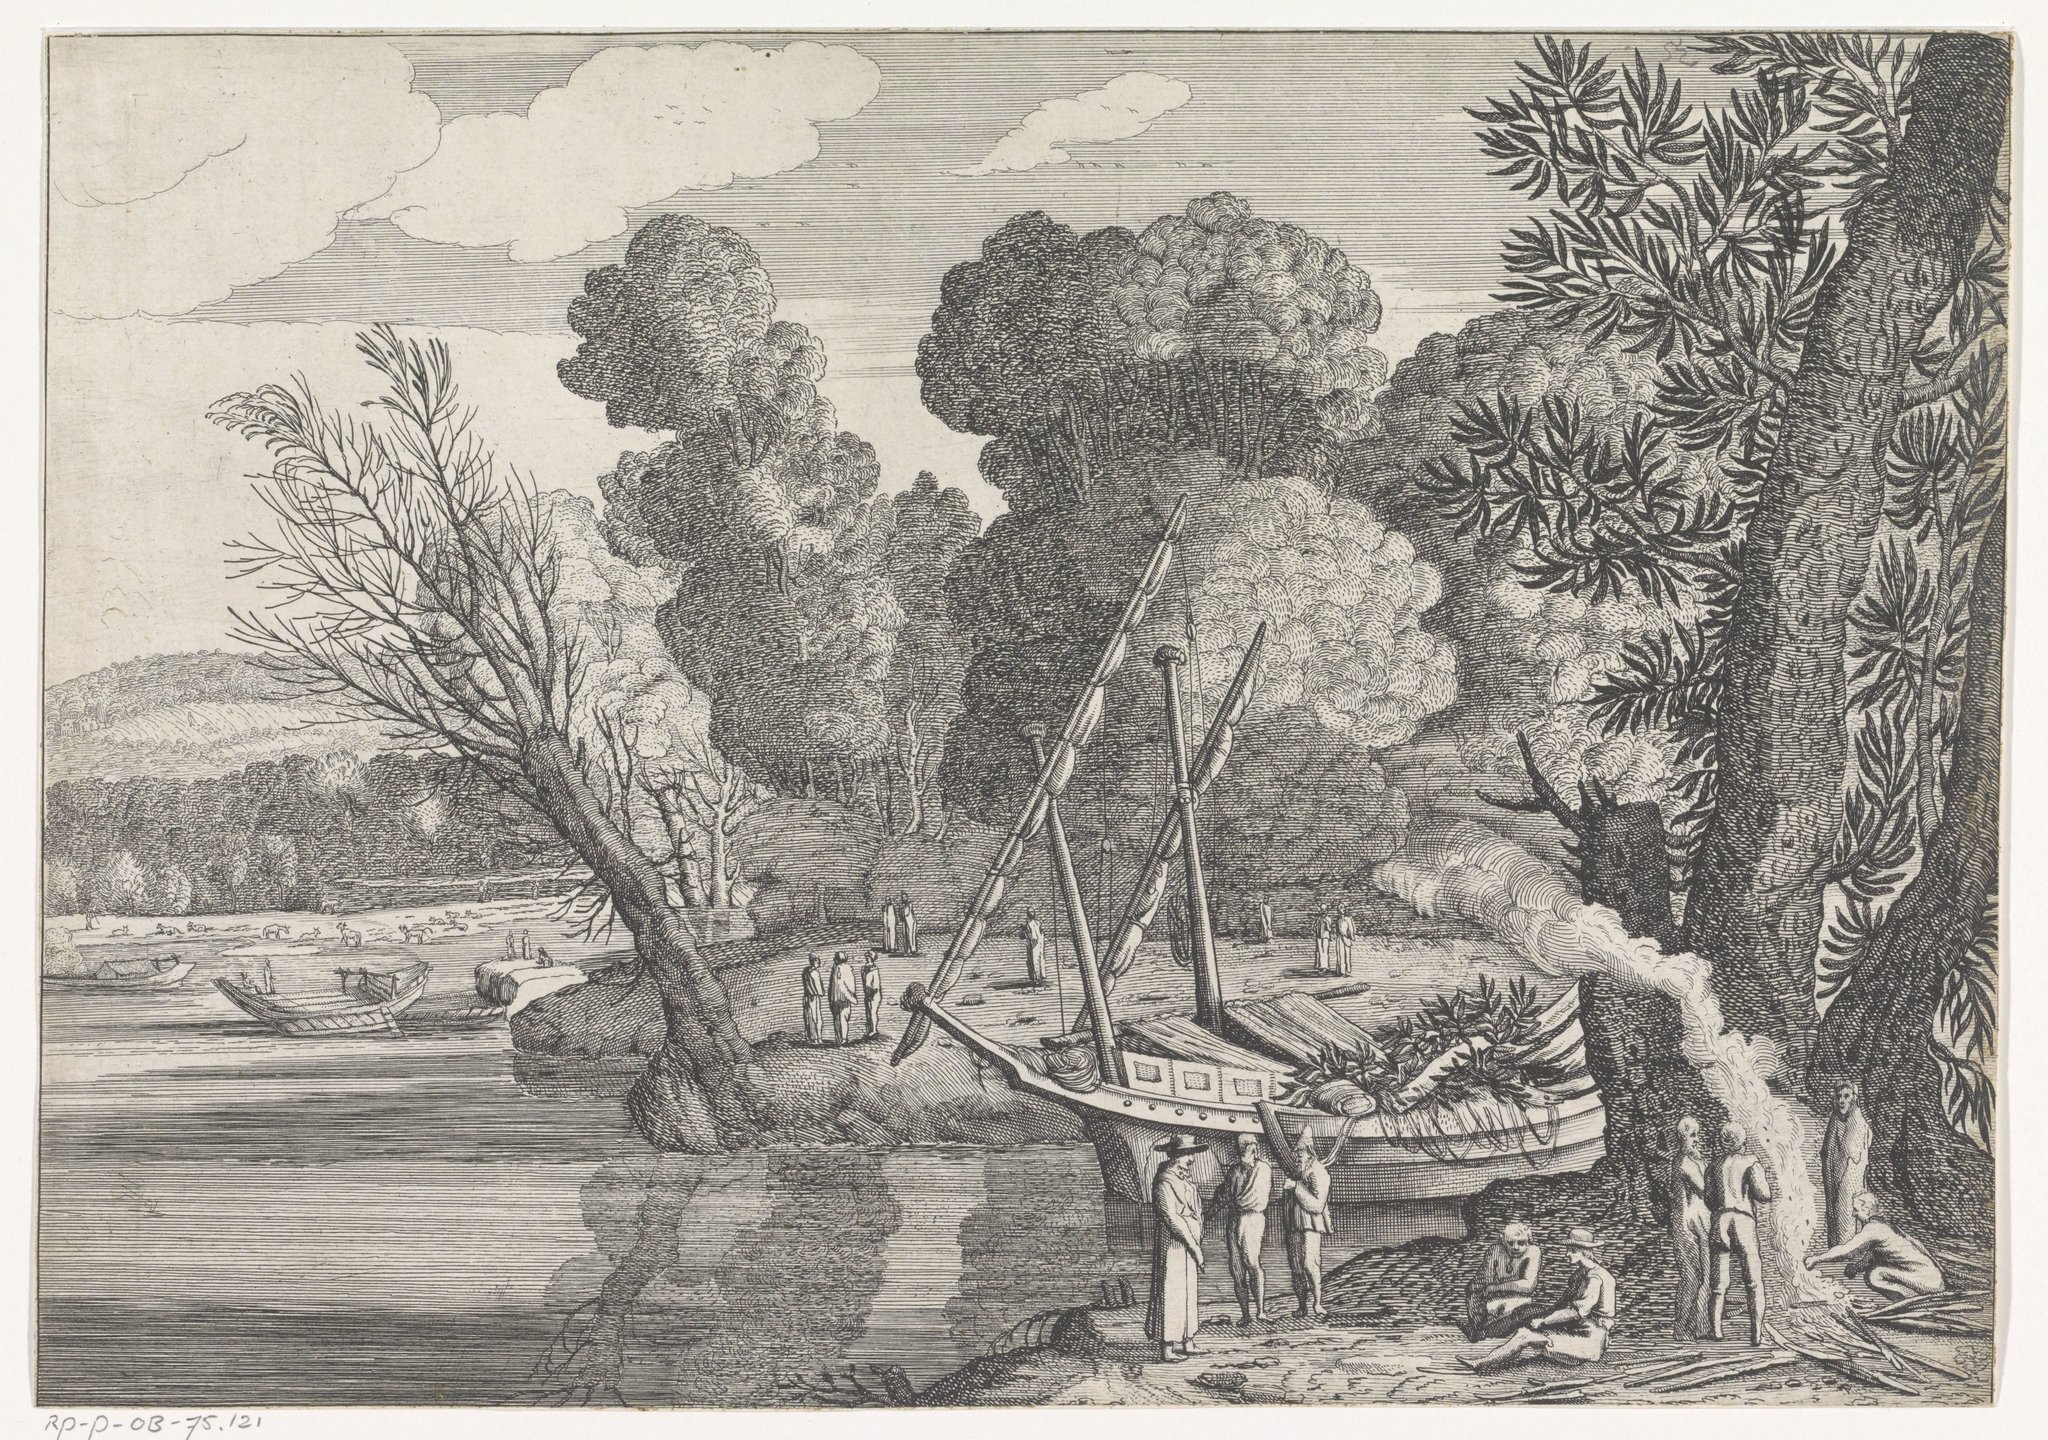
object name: print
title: Kustlandschap met schip en figuren rond een vuur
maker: Anonymous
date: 1700-1900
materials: paper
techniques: engraving, etching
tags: sailing-ship, sailing-boat, camp-fire; watch-fire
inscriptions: collector's mark: Lugt 2228